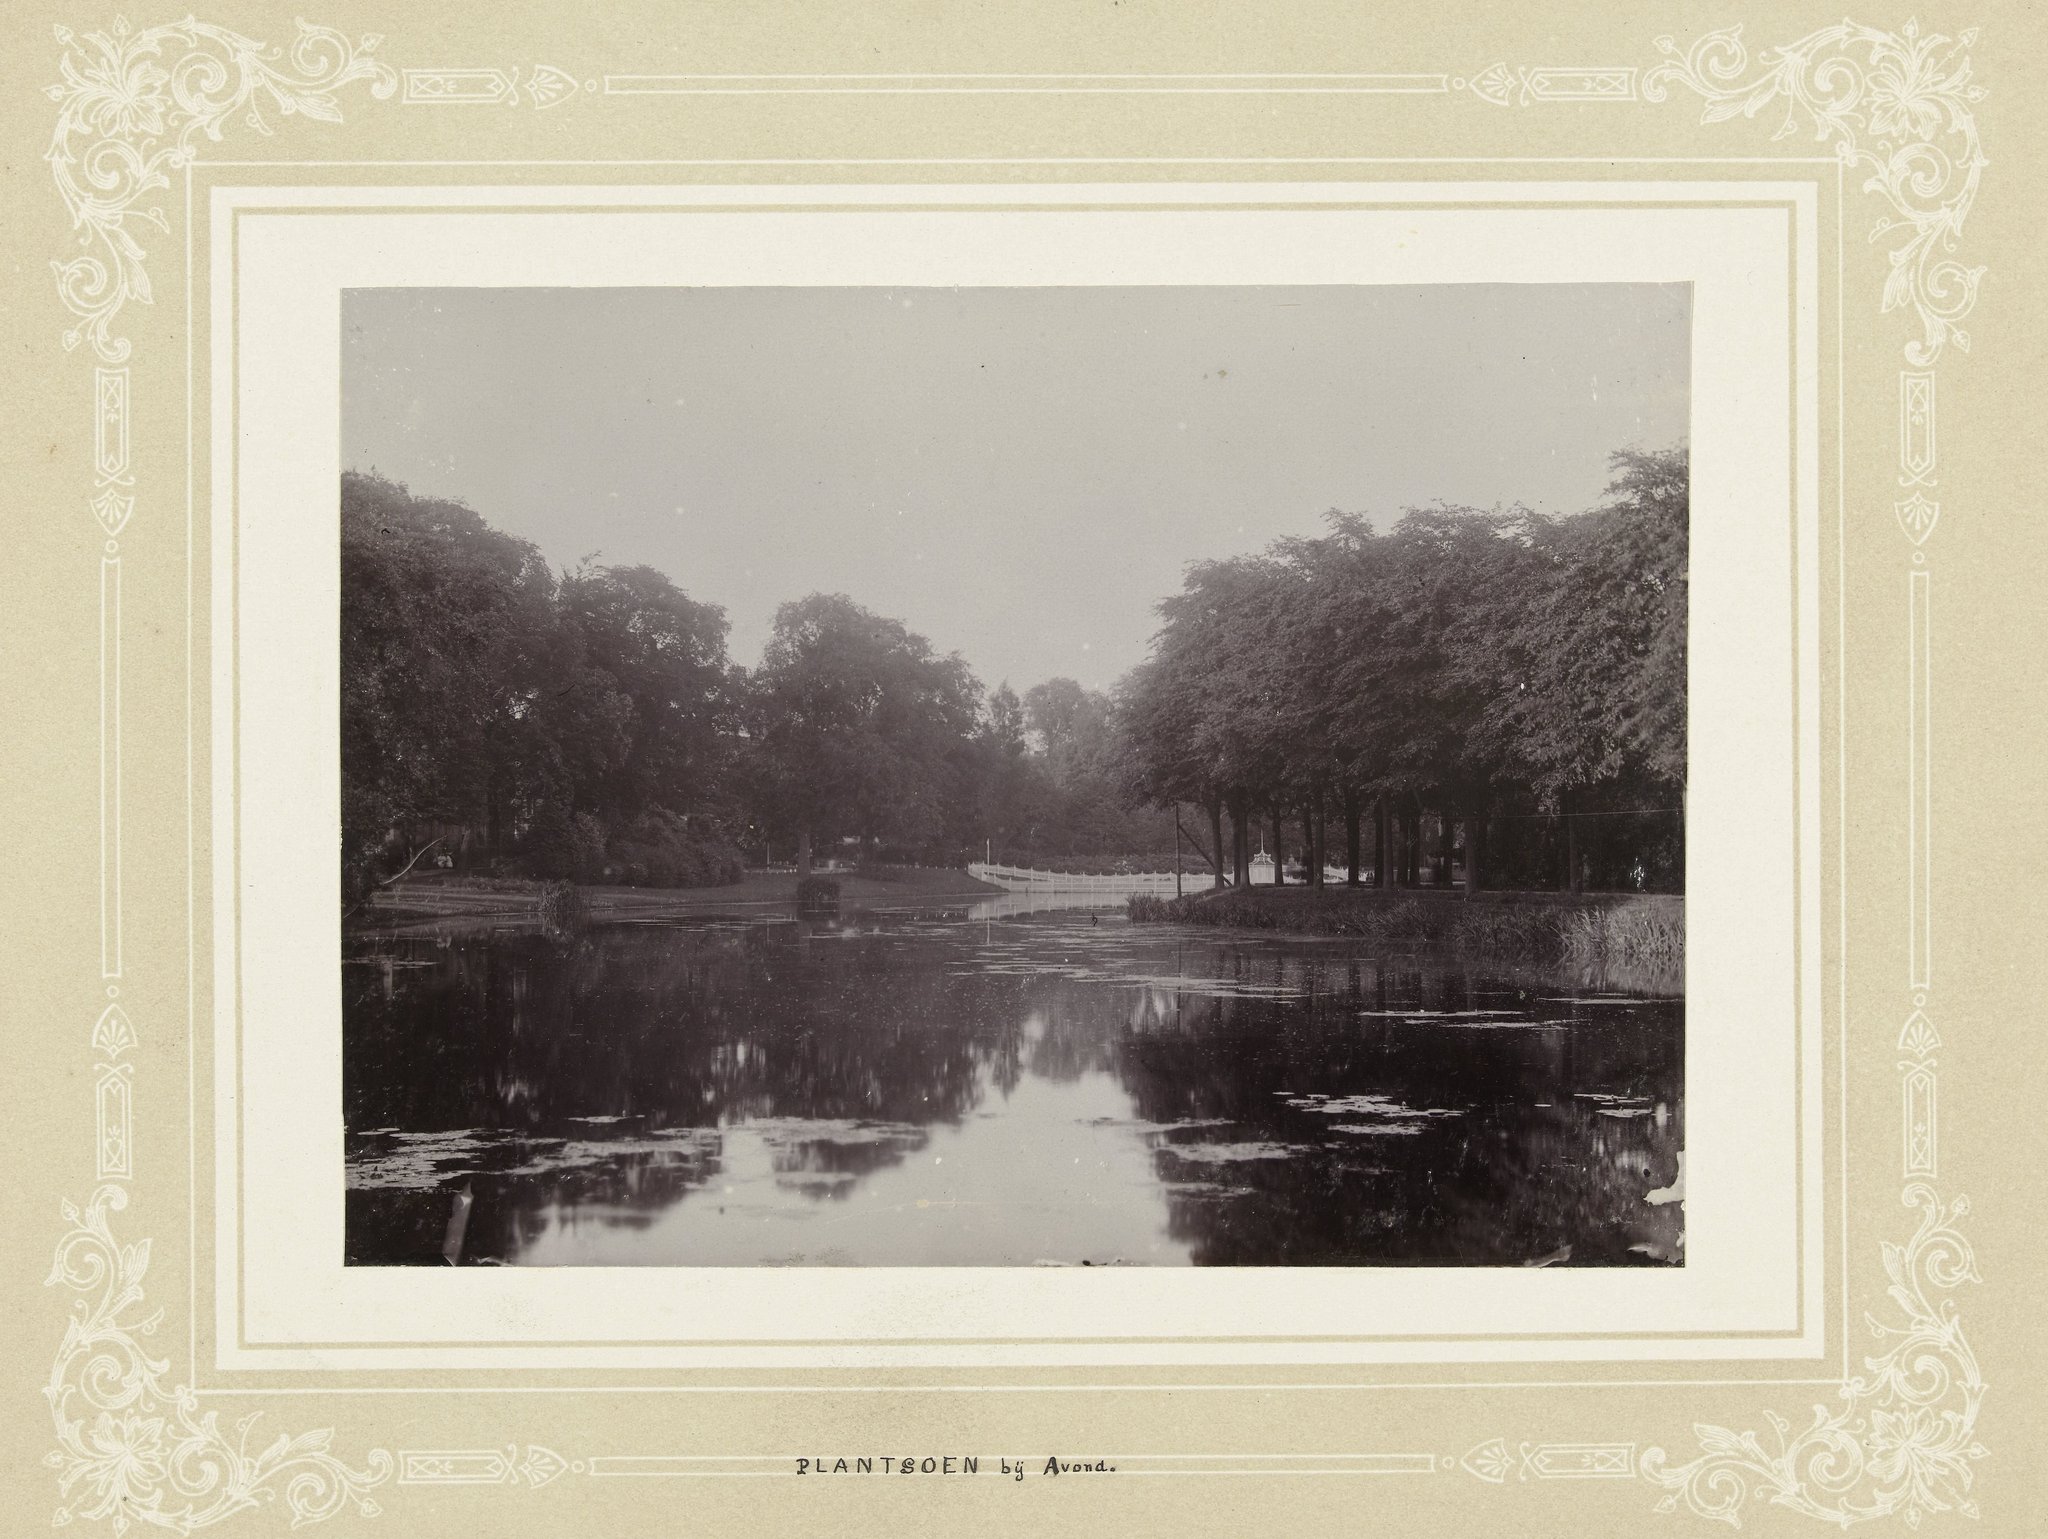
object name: photograph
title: Plantsoen bij avond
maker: Anonymous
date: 1900-1910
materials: paper, cardboard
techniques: collodion silver print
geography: leiden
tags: park, leiden